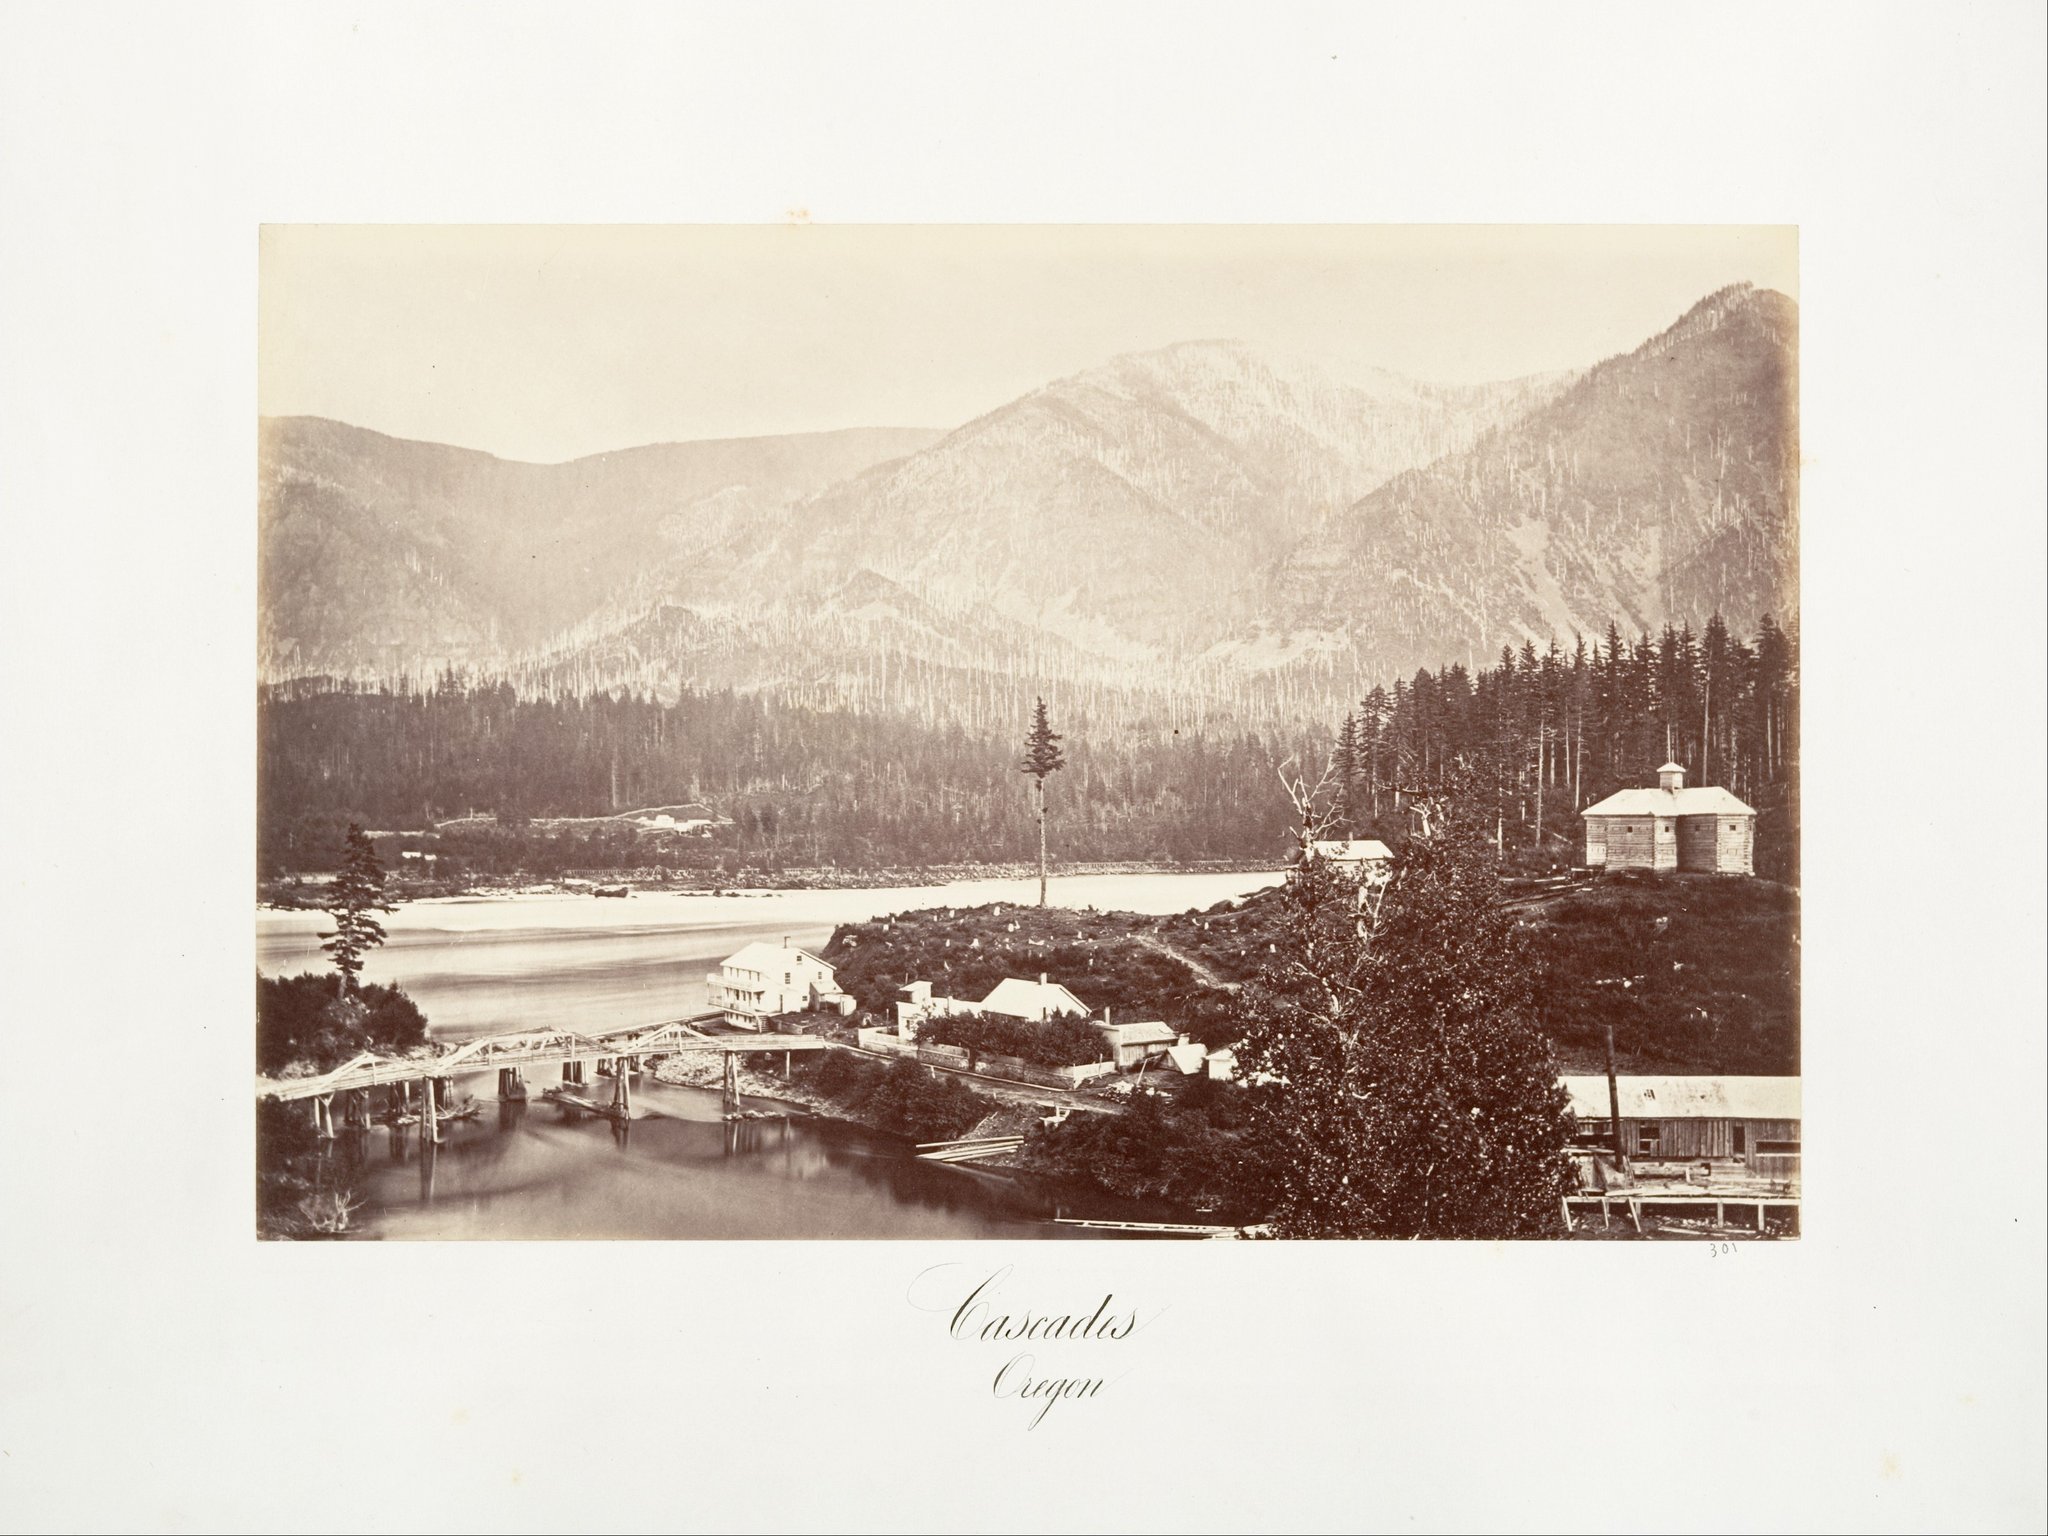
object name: photograph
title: Cascades, Oregon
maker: carleton e. watkins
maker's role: artist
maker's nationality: american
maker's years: 1829-1916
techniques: albumen silver print, glass negative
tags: bridges,mountains,landscapes